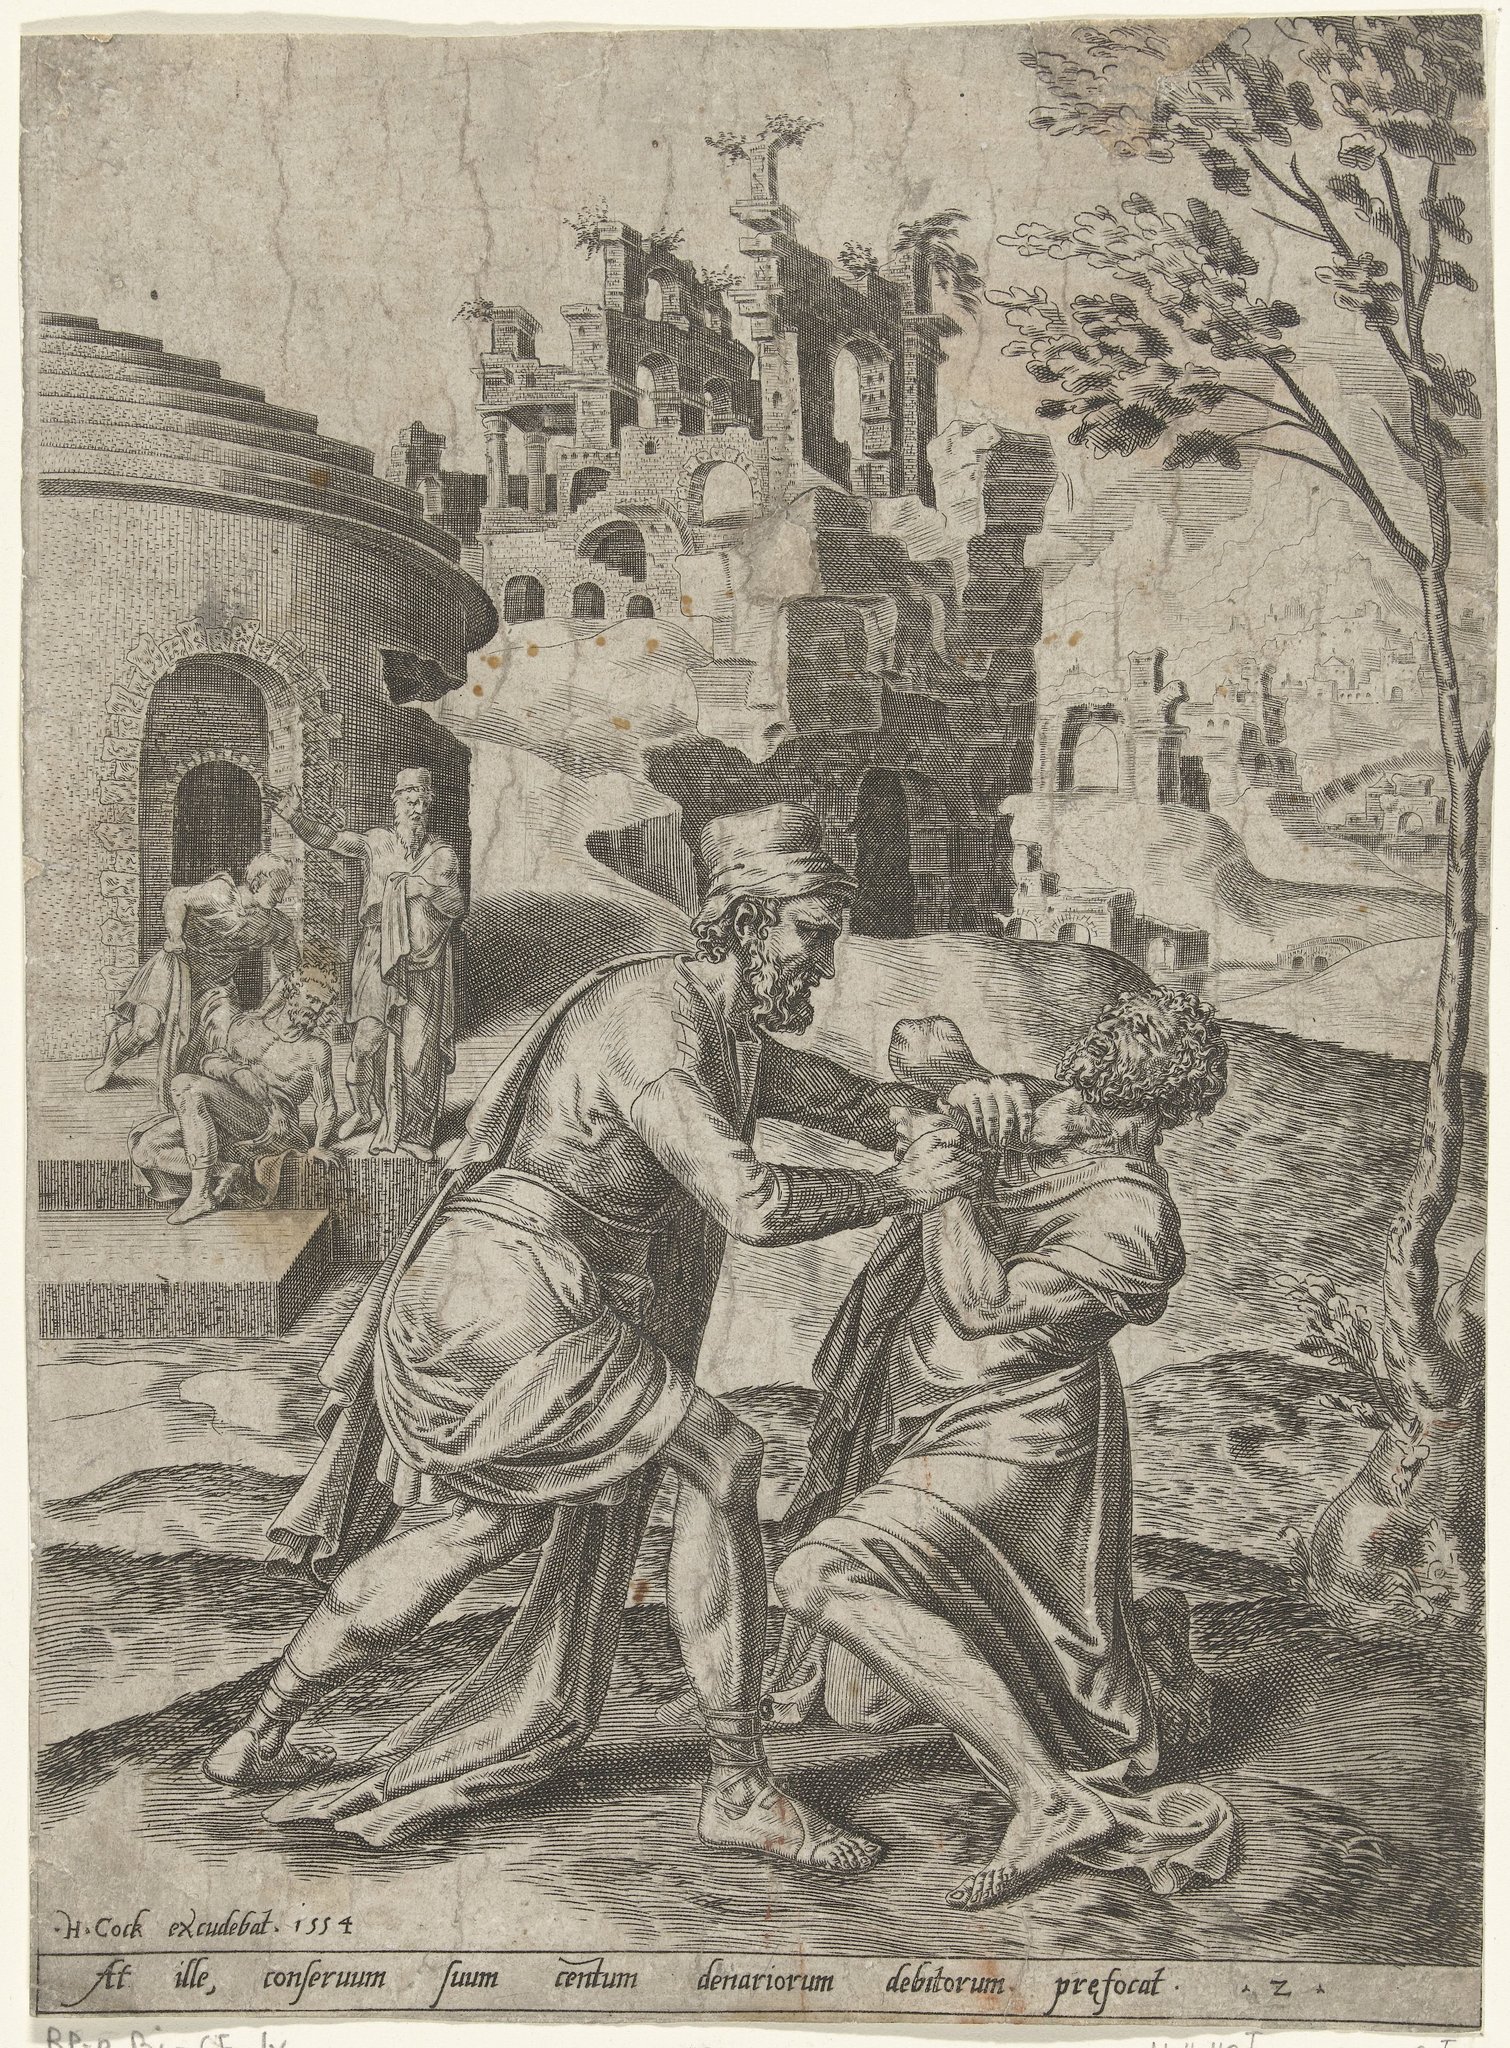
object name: print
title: Gelijkenis van de ondankbare knecht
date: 1554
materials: paper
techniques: engraving, etching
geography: antwerp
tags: the unmerciful servant attacks his fellow-servant who owes him money, and casts him into prison ~ parable of the unmerciful servant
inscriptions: initials: ‘D.’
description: De ondankbare knecht valt een van zijn schuldenaars aan, wurgt hem en eist zijn geld terug. De prent heeft een Latijns onderschrift en maakt deel uit van een vierdelige serie over de gelijkenis van de ondankbare knecht.